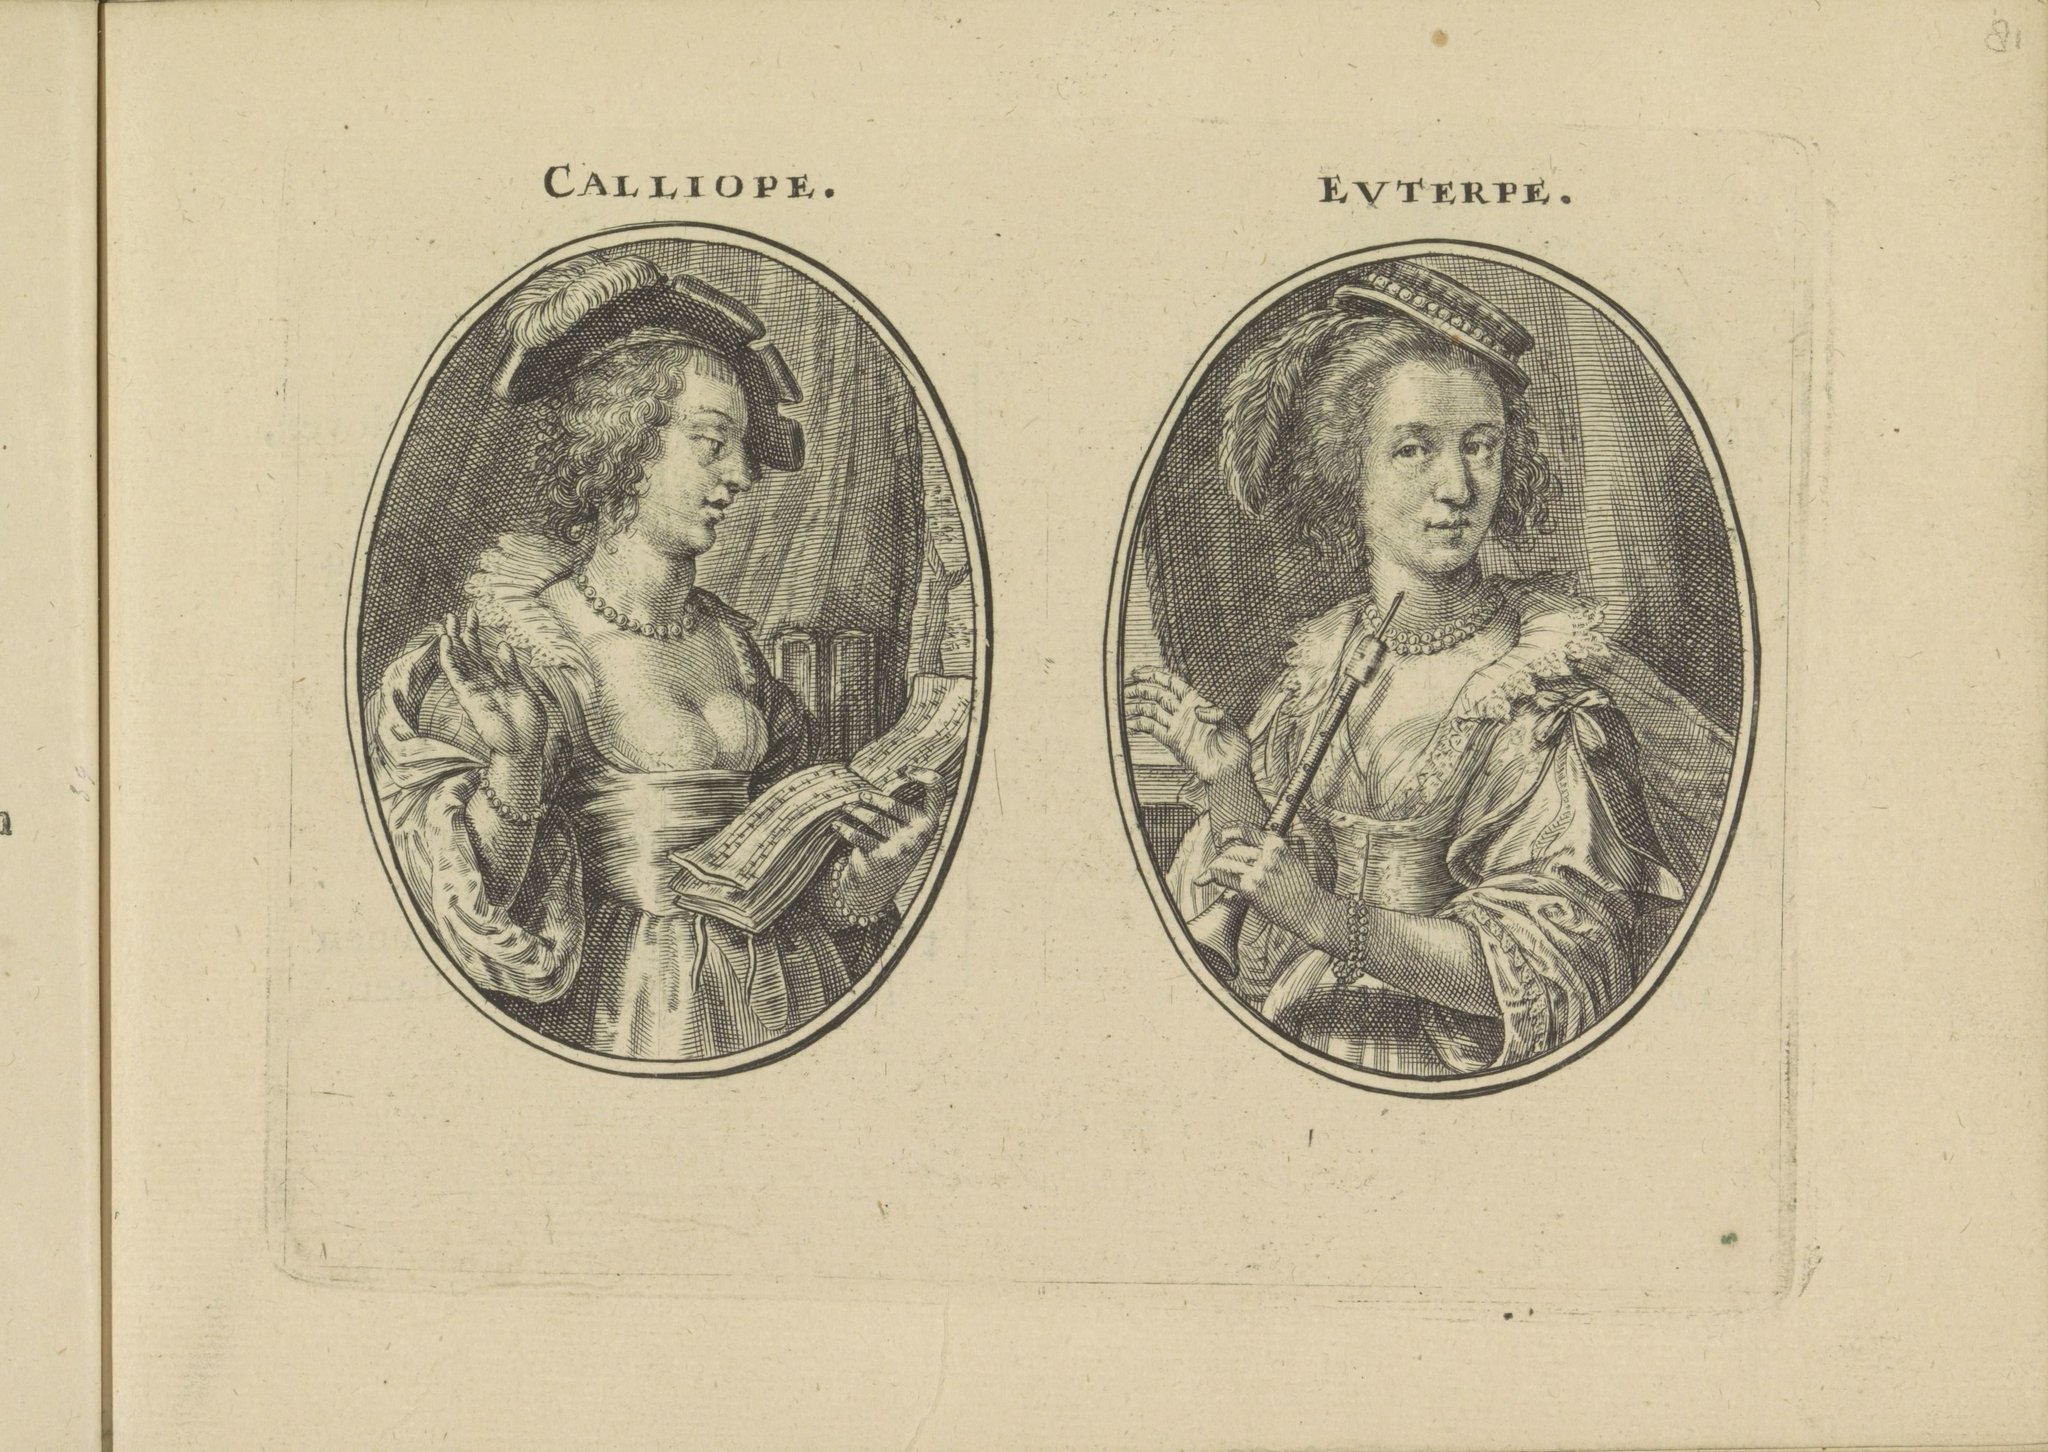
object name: print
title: Calliope en Euterpe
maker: crispijn van de passe (ii)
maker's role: draughtsman, print maker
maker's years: 1594-1670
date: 1640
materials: paper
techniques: engraving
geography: amsterdam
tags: notation of music, calliope (one of the muses); 'calliope' (ripa), clarinet, bassoon, oboe, shawm, euterpe (one of the muses); 'euterpe' (ripa)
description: Twee voorstellingen op een albumblad. Links de muze Calliope, zingend uit een muziekboek. Rechts de muze Euterpe met schalmei. Het blad maakt deel uit van een album.